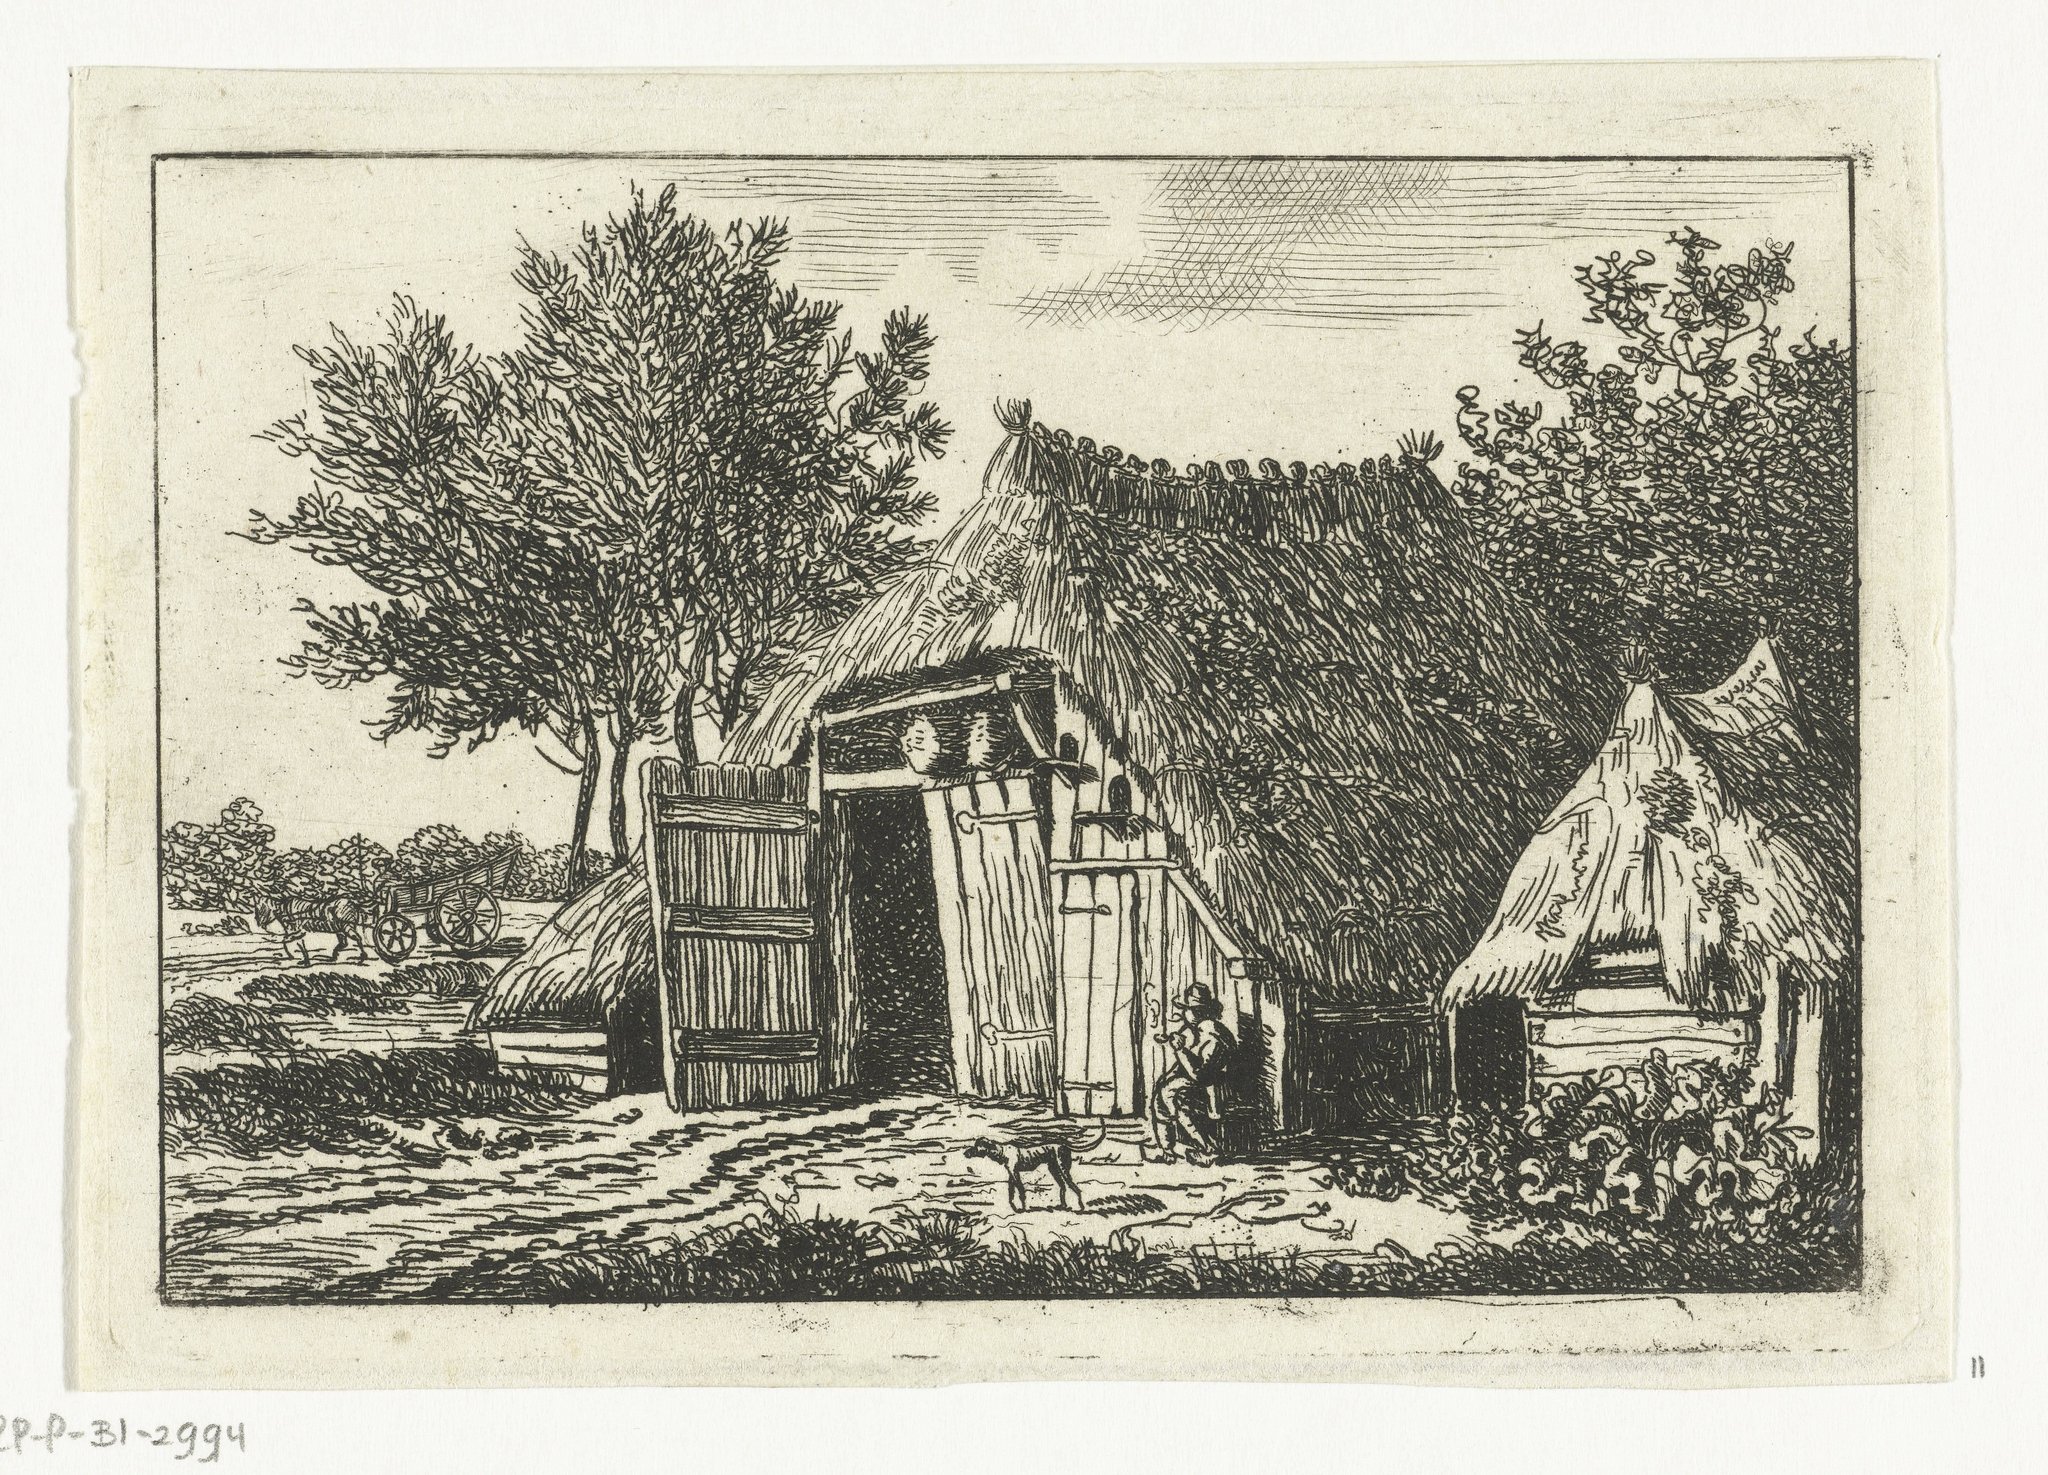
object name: print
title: Pijprokende man zittend voor schuur buiten Hattem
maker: anthonie van den bos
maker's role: draughtsman, print maker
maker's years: 1763-1838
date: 1778-1838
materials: paper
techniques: drypoint, etching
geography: netherlands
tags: barn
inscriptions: collector's mark: Lugt 2228